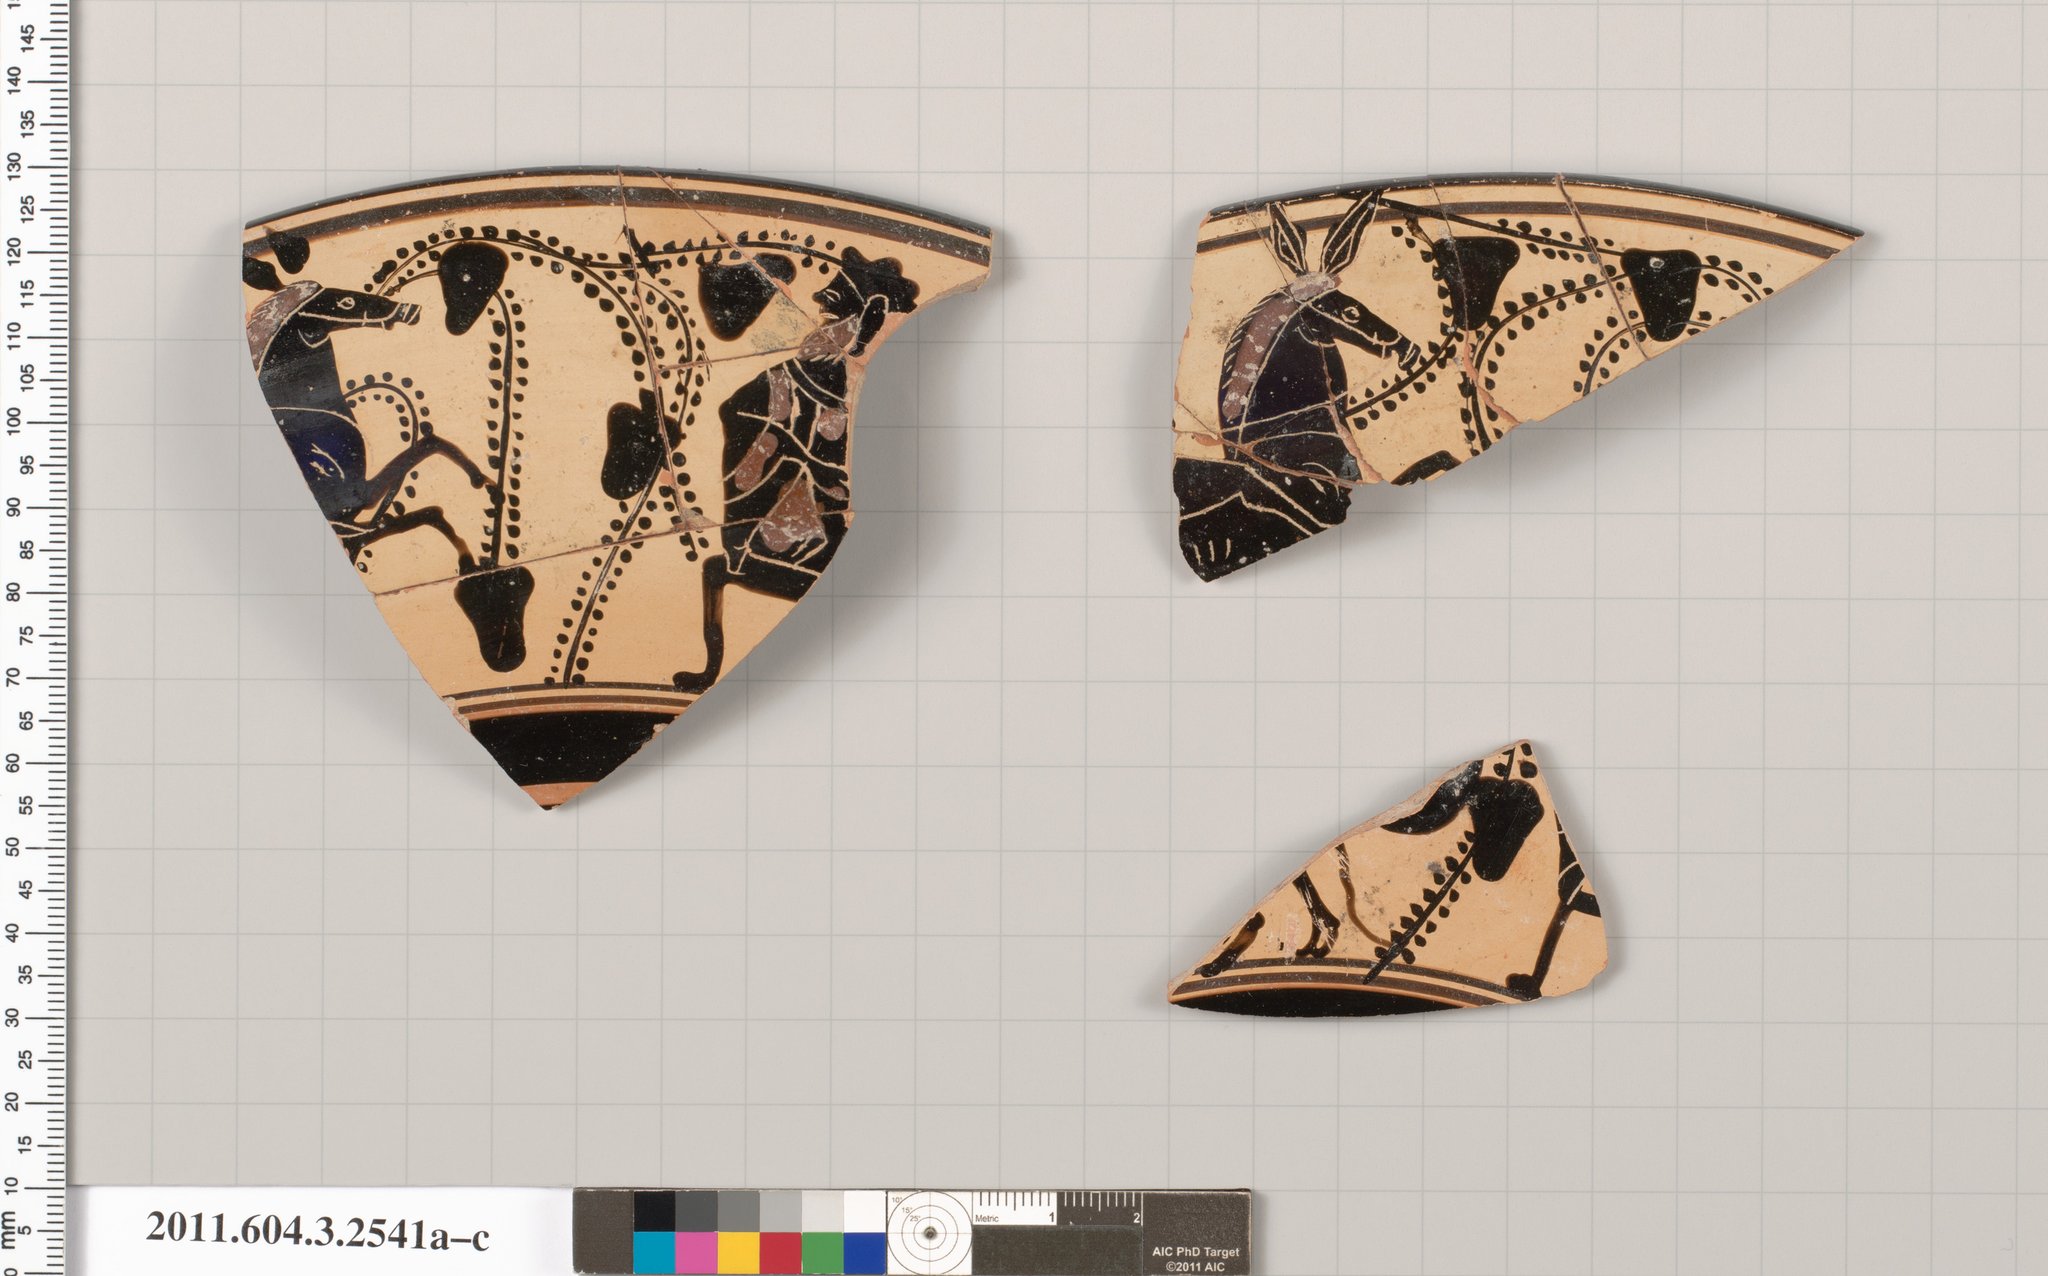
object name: kylix fragment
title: Terracotta fragments of a kylix (drinking cup)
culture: greek, attic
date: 534-468 BCE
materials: terracotta